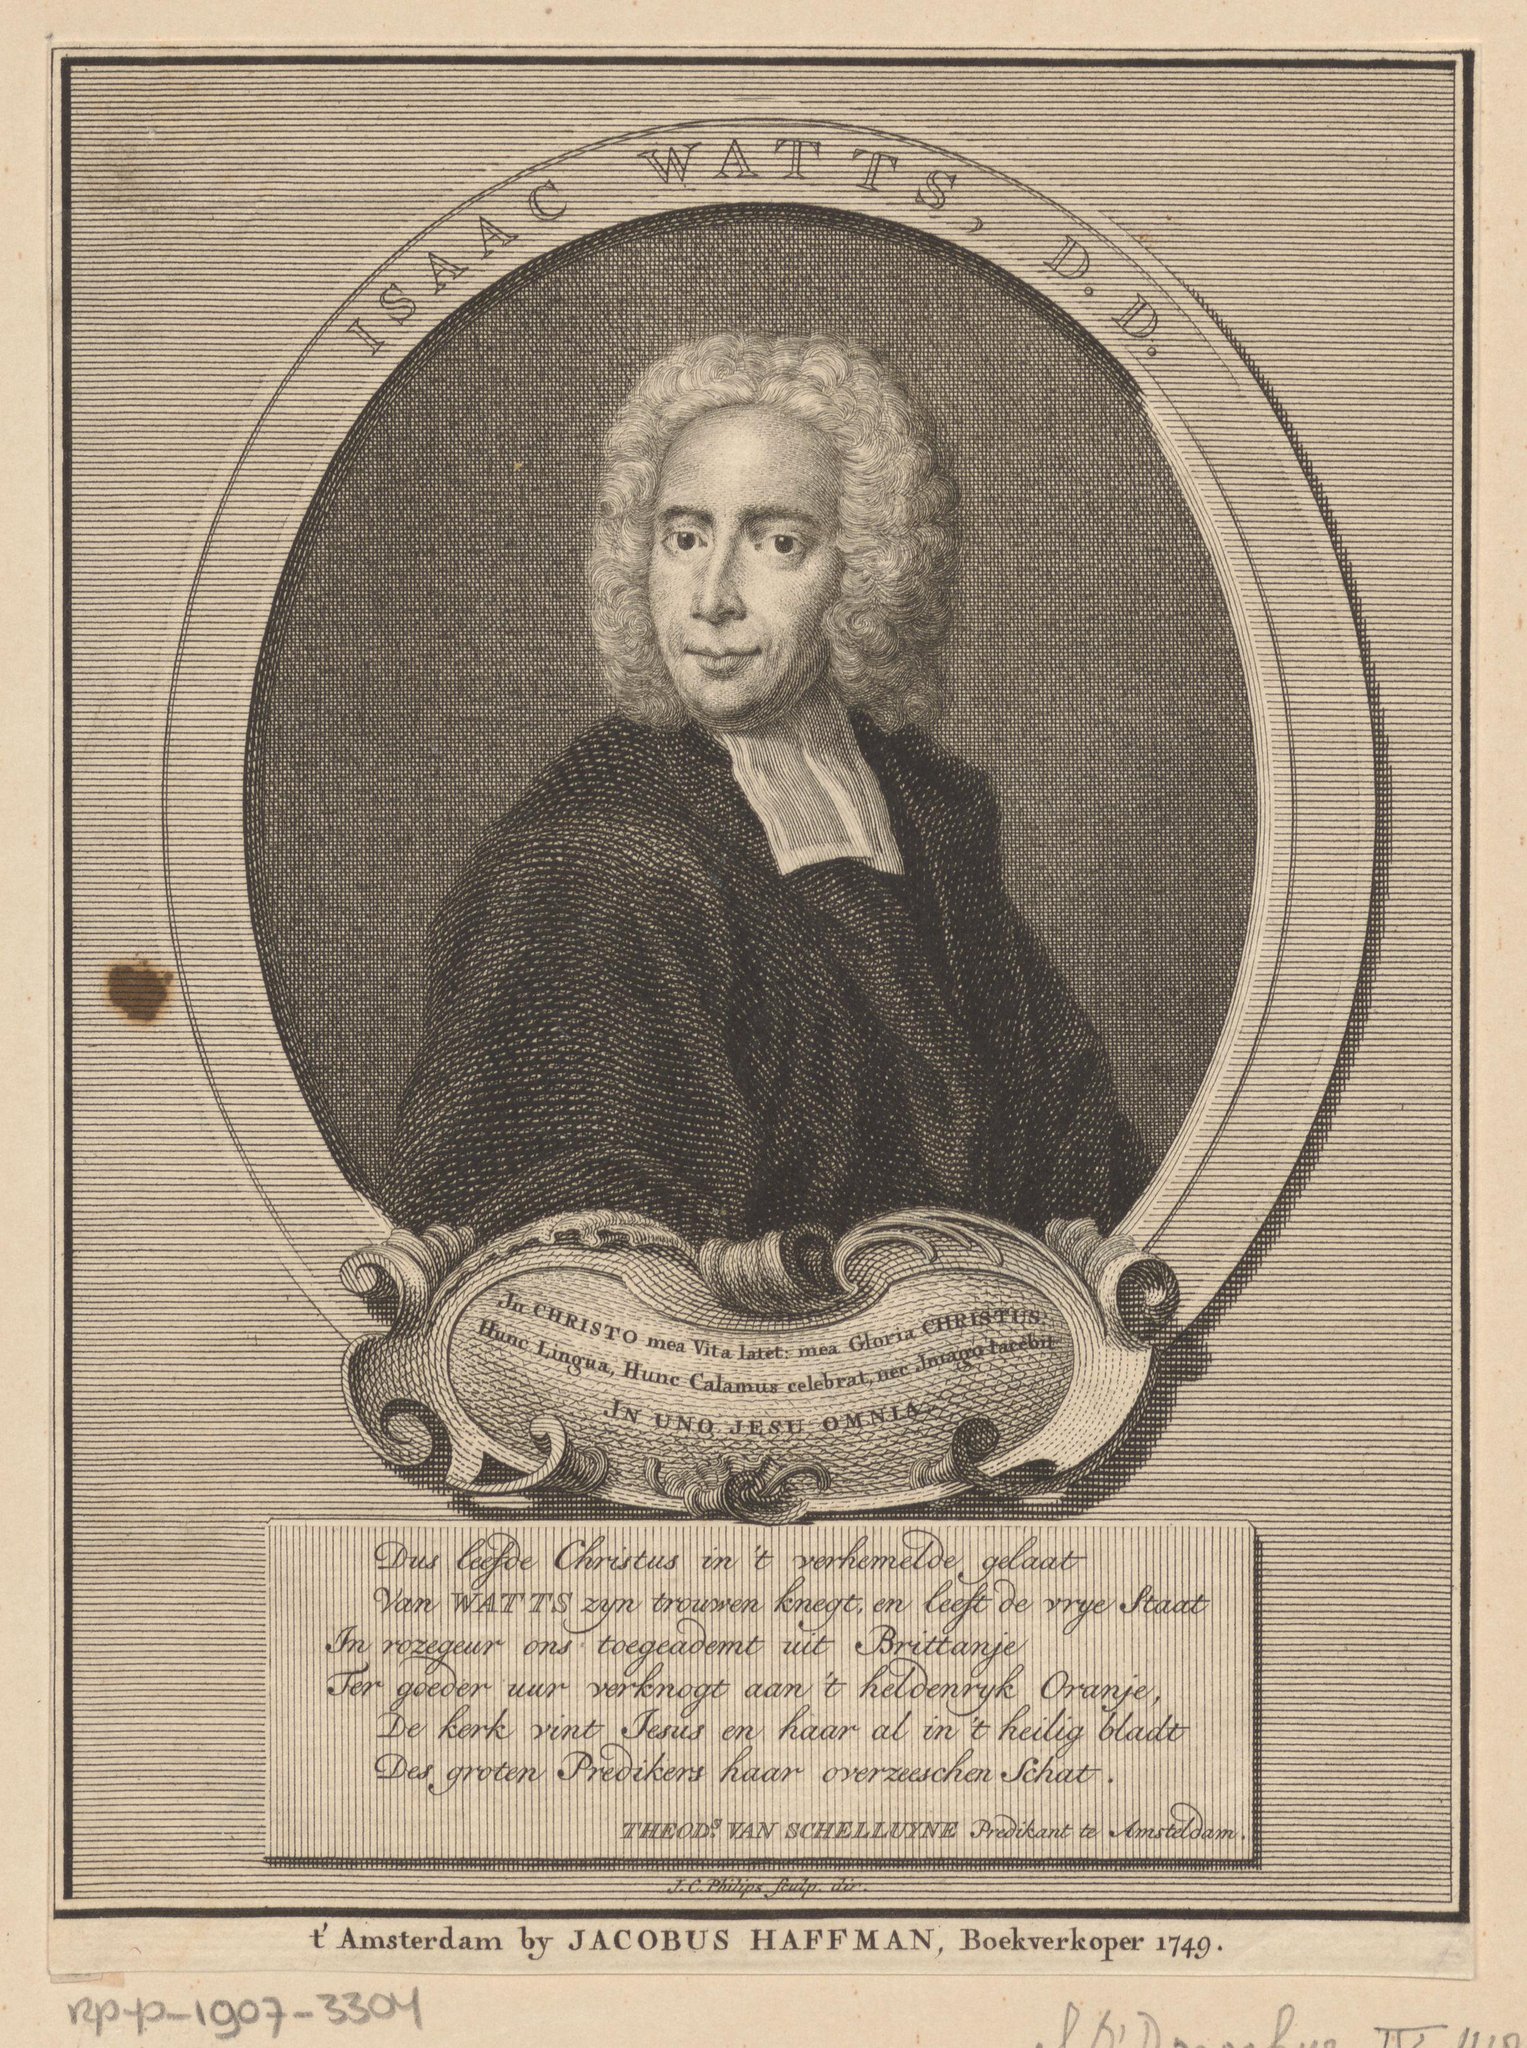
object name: print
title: Portret van Isaac Watts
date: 1749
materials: paper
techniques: engraving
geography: amsterdam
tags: theologian, historical persons, portrait of a writer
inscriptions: collector's mark: Lugt 2228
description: Onder het portret een zesregelig vers in het Nederlands.